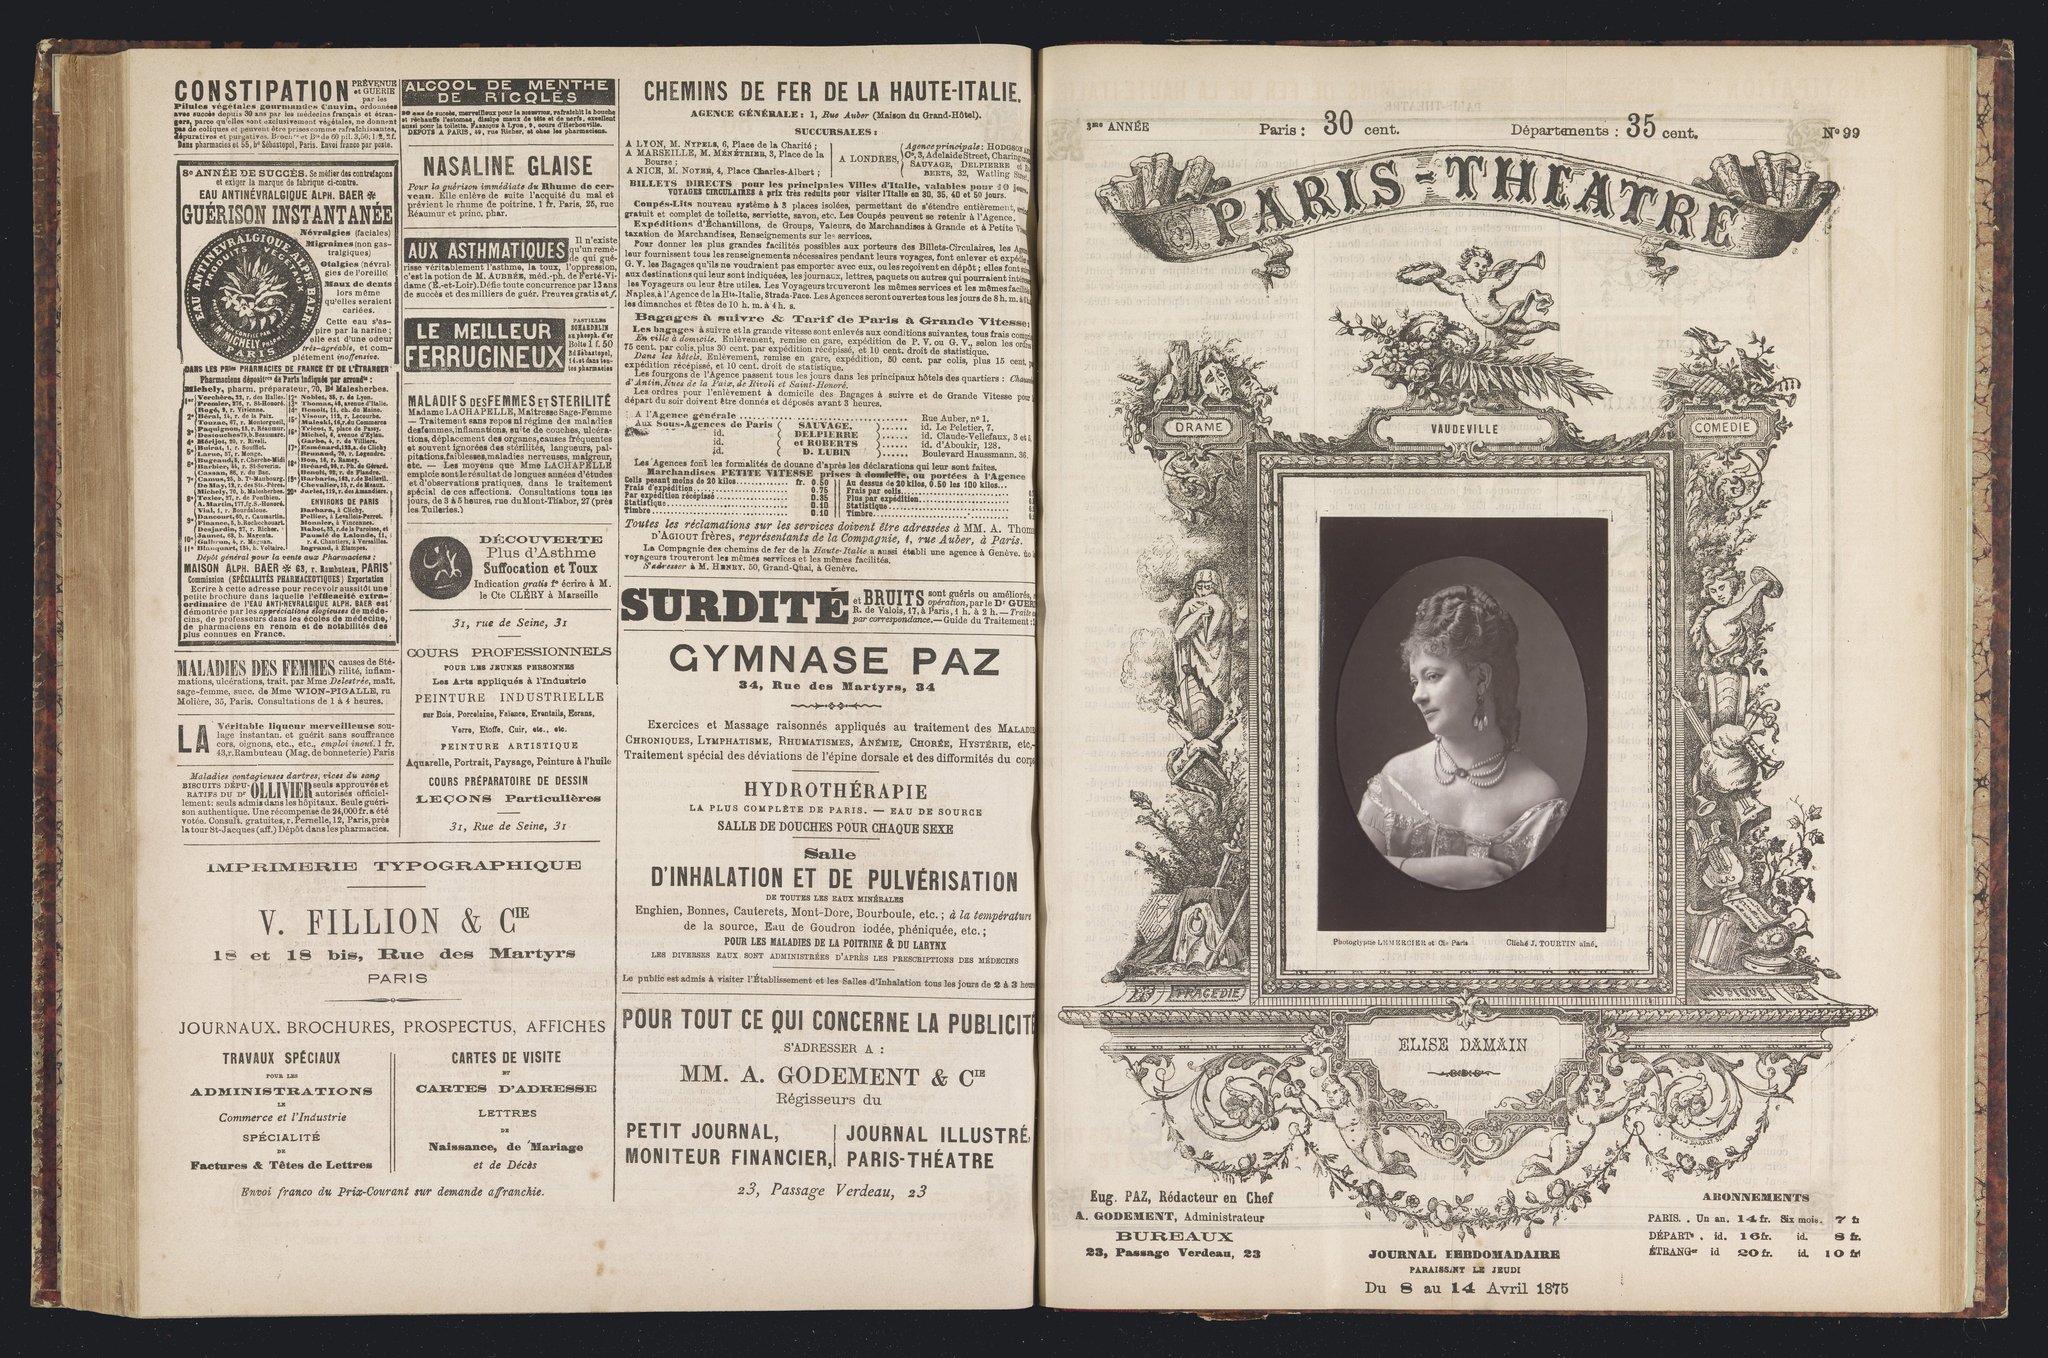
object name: page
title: Portret van Elise Damain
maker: j. tourtin (lainé)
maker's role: fotograaf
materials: paper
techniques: woodburytype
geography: france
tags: portrait of actor, actress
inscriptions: number: ‘No 99’, inscription: ‘Journal hebdomadaire paraissant le jeudi Du 8 au 14 Avril 1875’